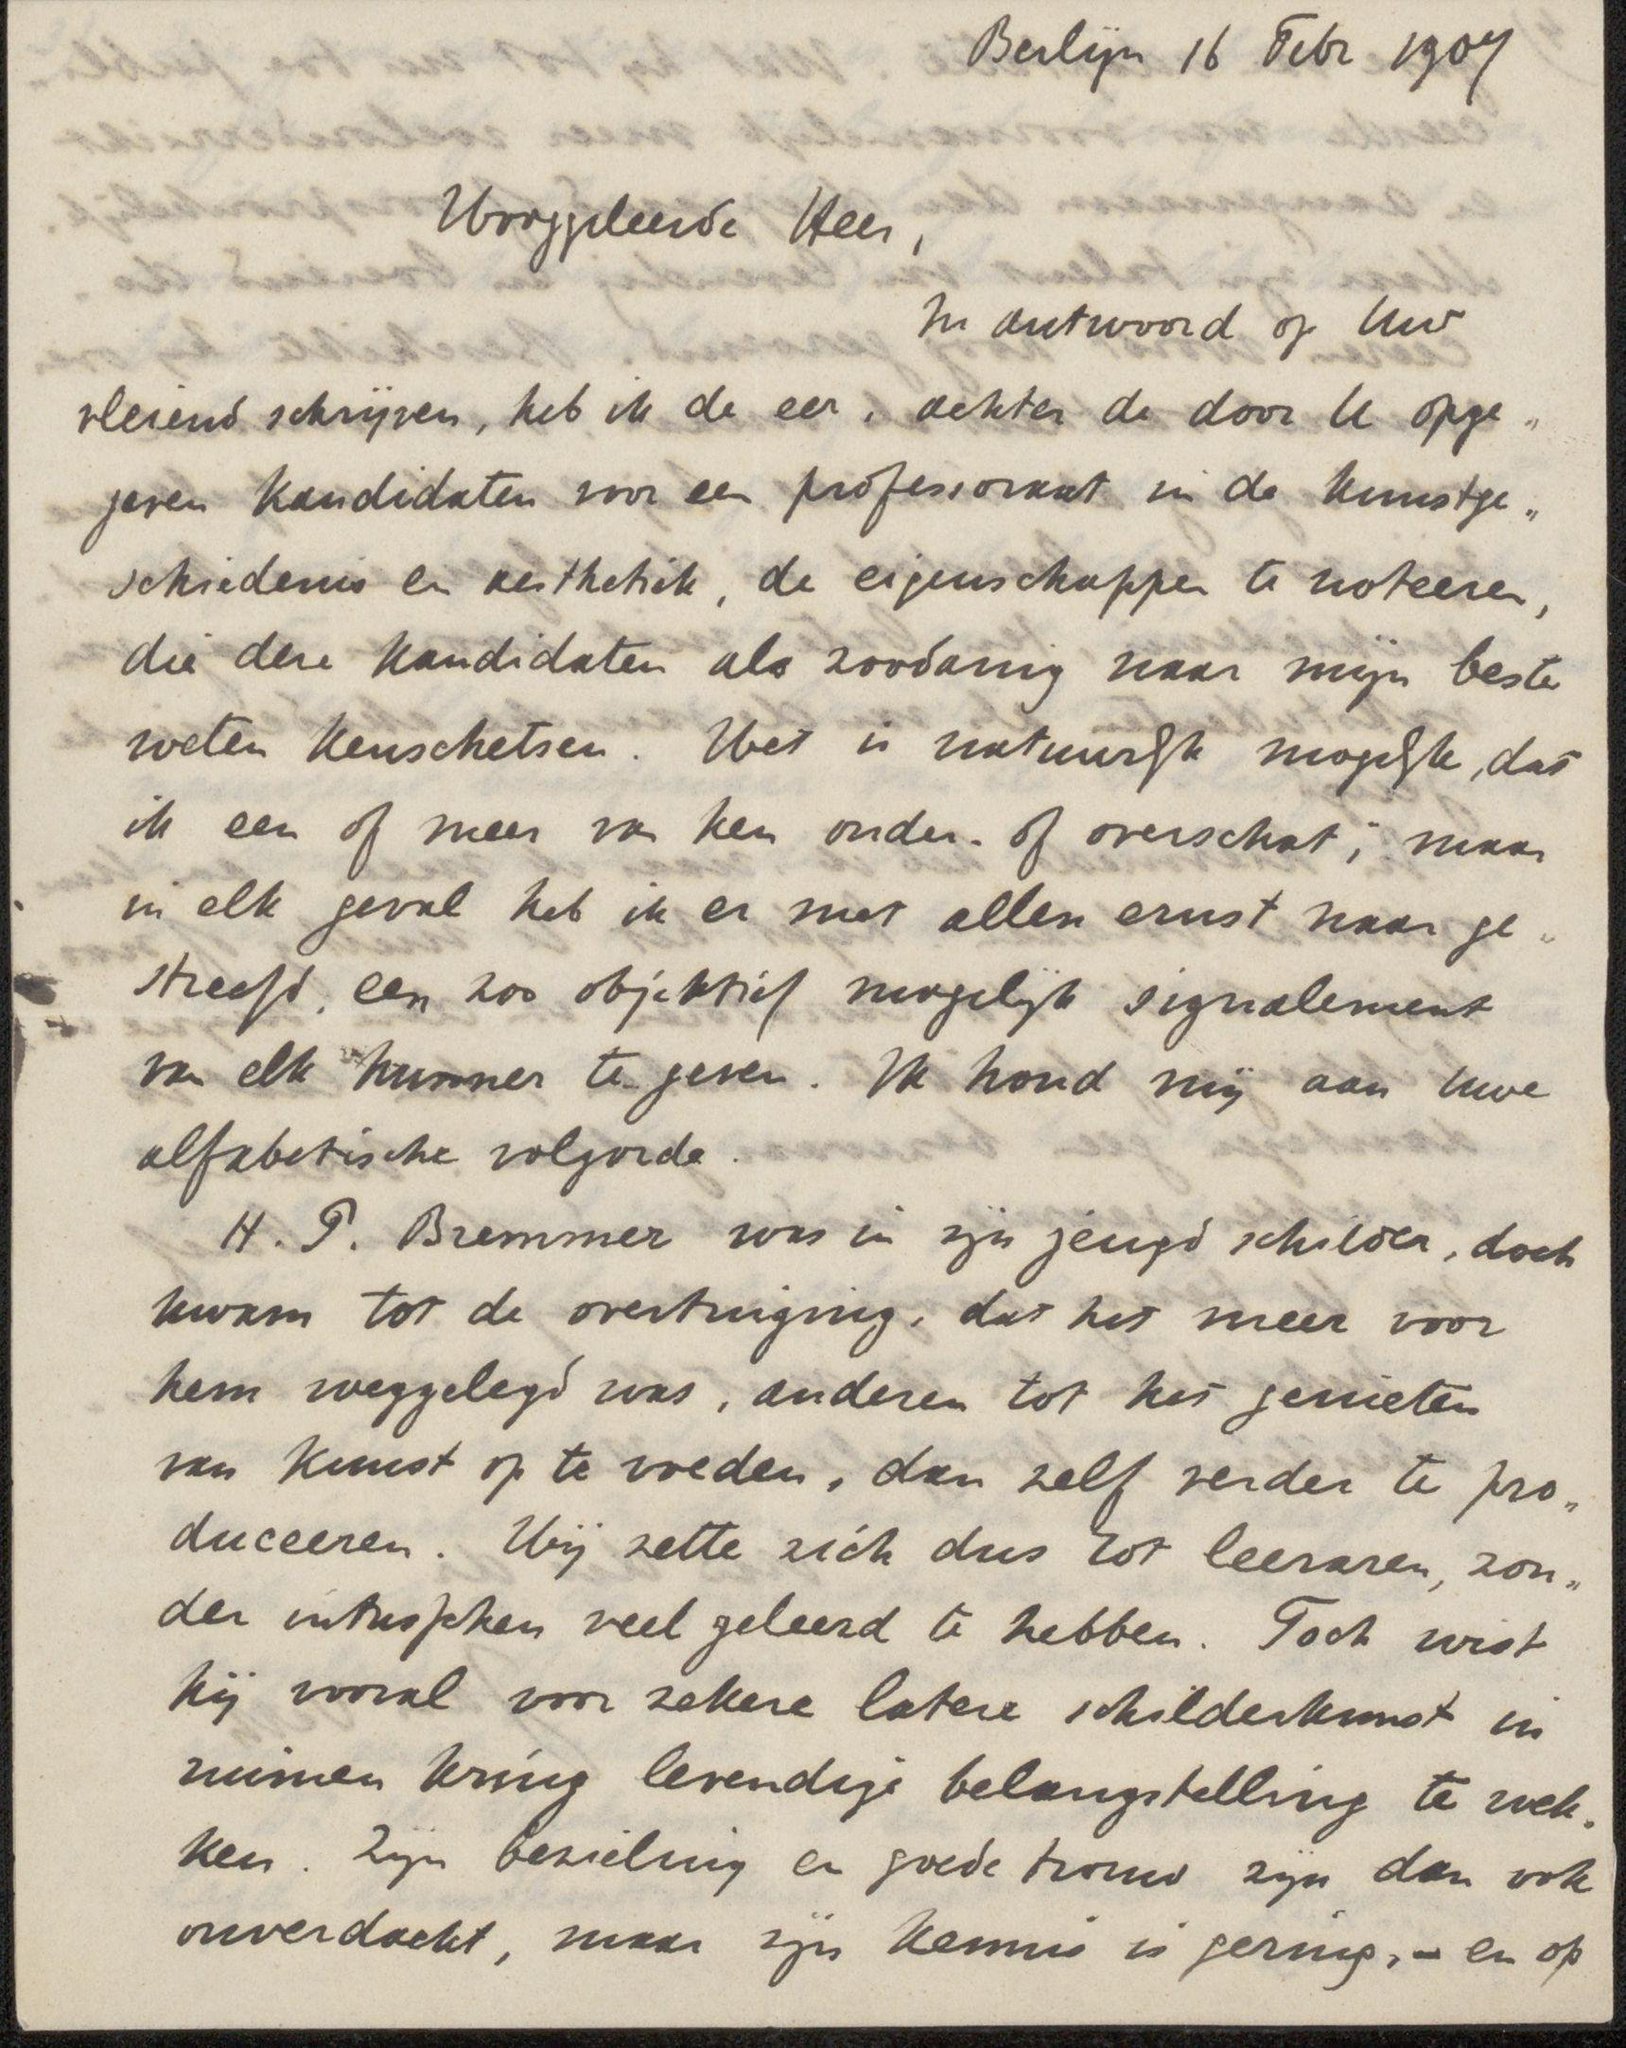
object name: letter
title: Brief aan Samuel Muller (1848-1922)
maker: jan veth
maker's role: designer, draughtsman, painter, print maker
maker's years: 1864-1925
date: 1907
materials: ink, paper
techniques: pen, writing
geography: berlin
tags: leiden, hendricus petrus bremmer, nijmegen, print maker, adriaan pit, utrecht, willem vogelsang, samuel muller (1848-1922), cornelis hofstede de groot, the hague, painter, draughtsman, wilhelm martin, jan kalff, andré jolles, ernst wilhelm moes, sculpture, painting (including book-illumination, miniature-painting)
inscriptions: watermark, collector's mark: ‘RPK’